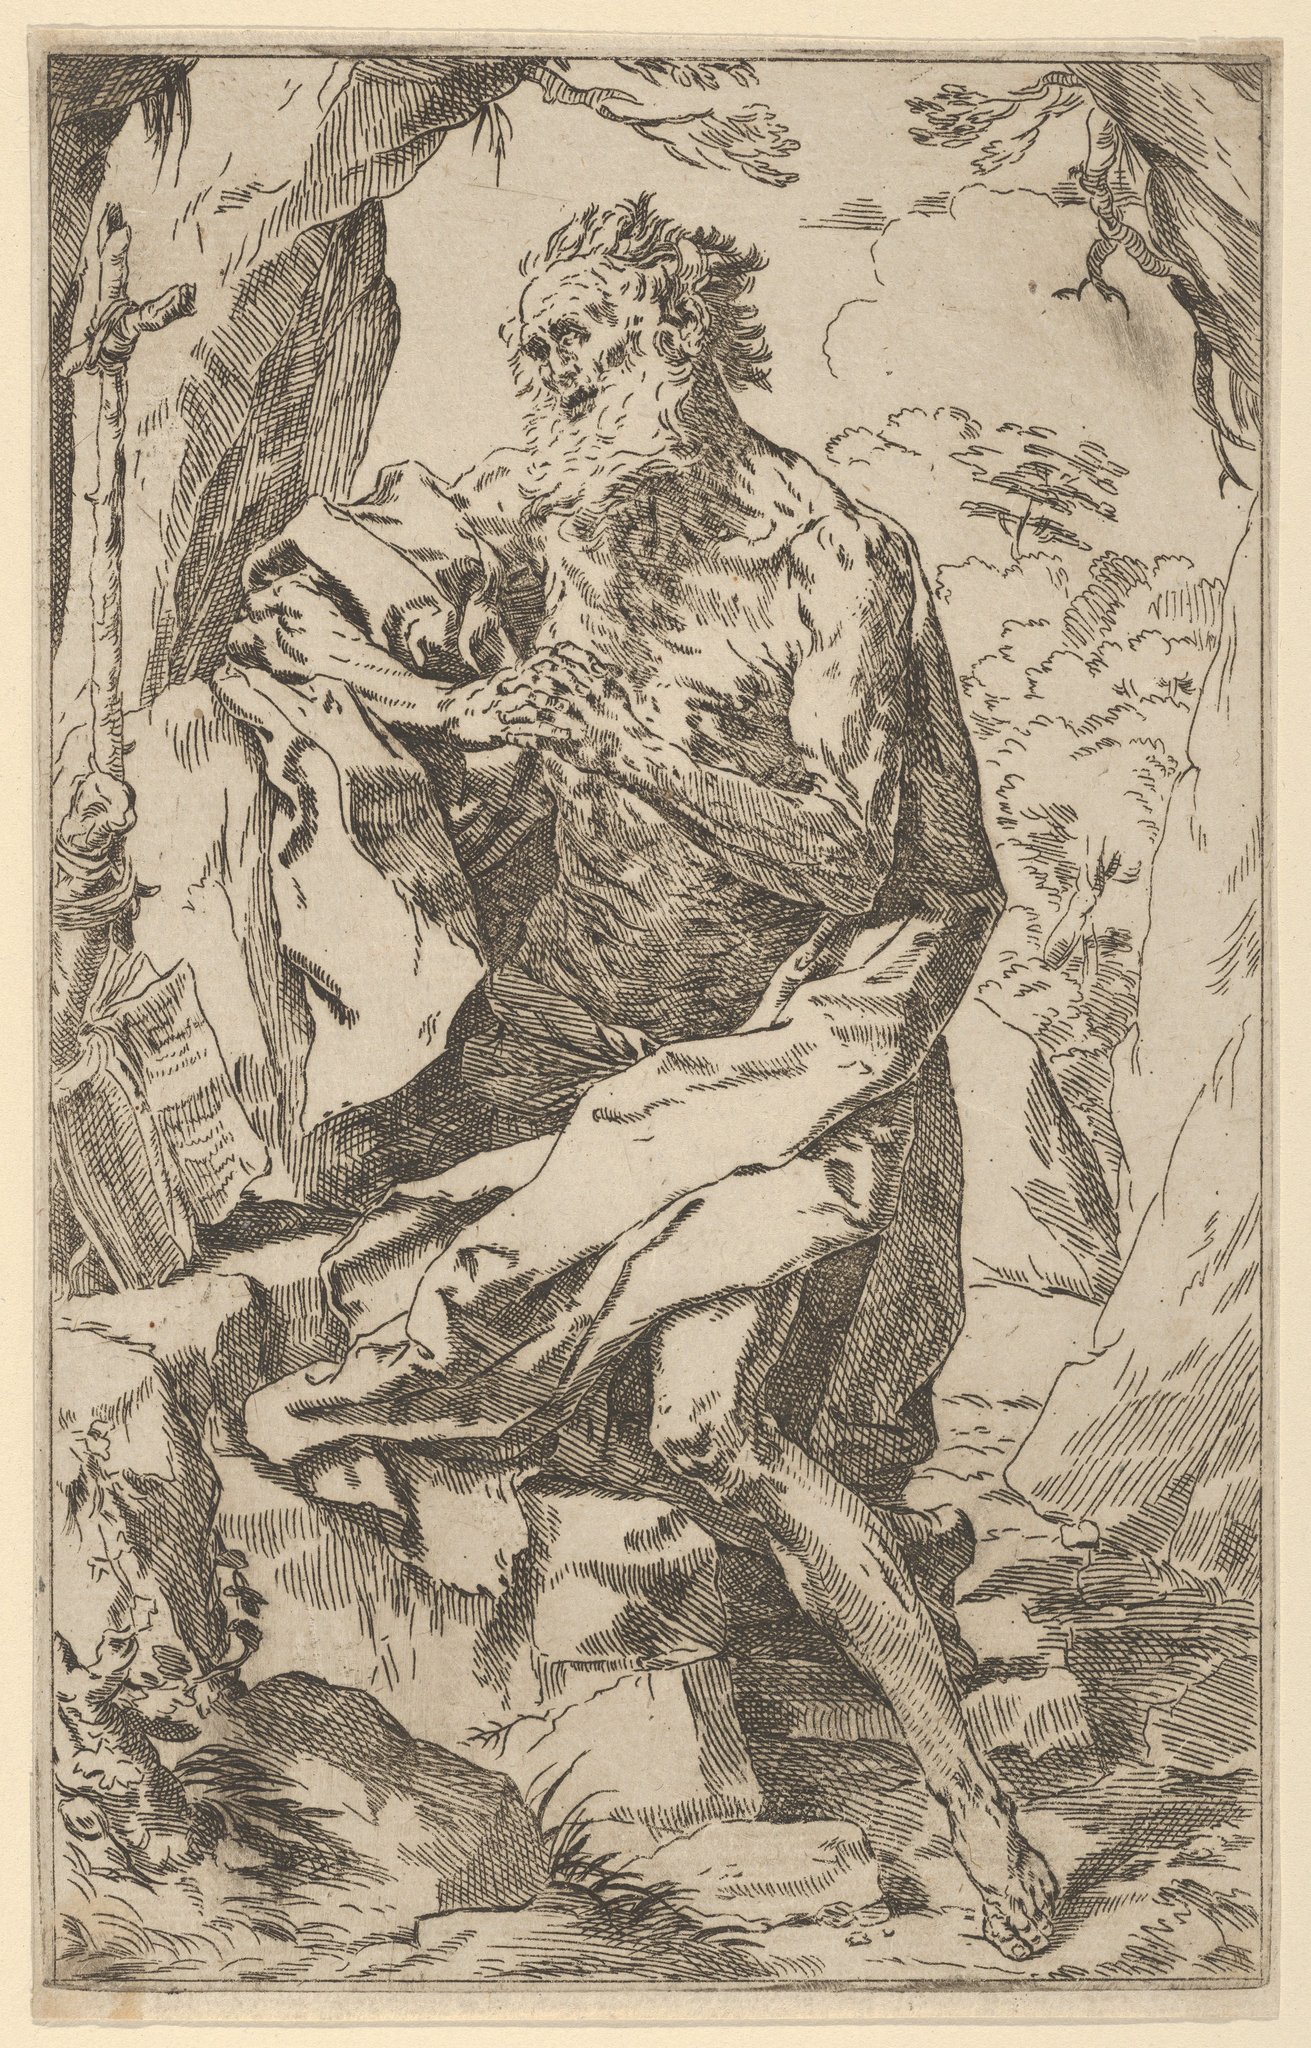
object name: print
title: Saint Jerome kneeling on a rock in front of a cross and an open book facing left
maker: anonymous, 17th century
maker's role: artist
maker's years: 1600-1700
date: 1600-1640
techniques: etching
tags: books,saint jerome,cross